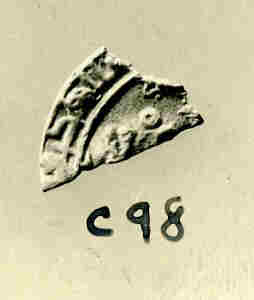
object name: coin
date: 401-1400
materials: gold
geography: iran